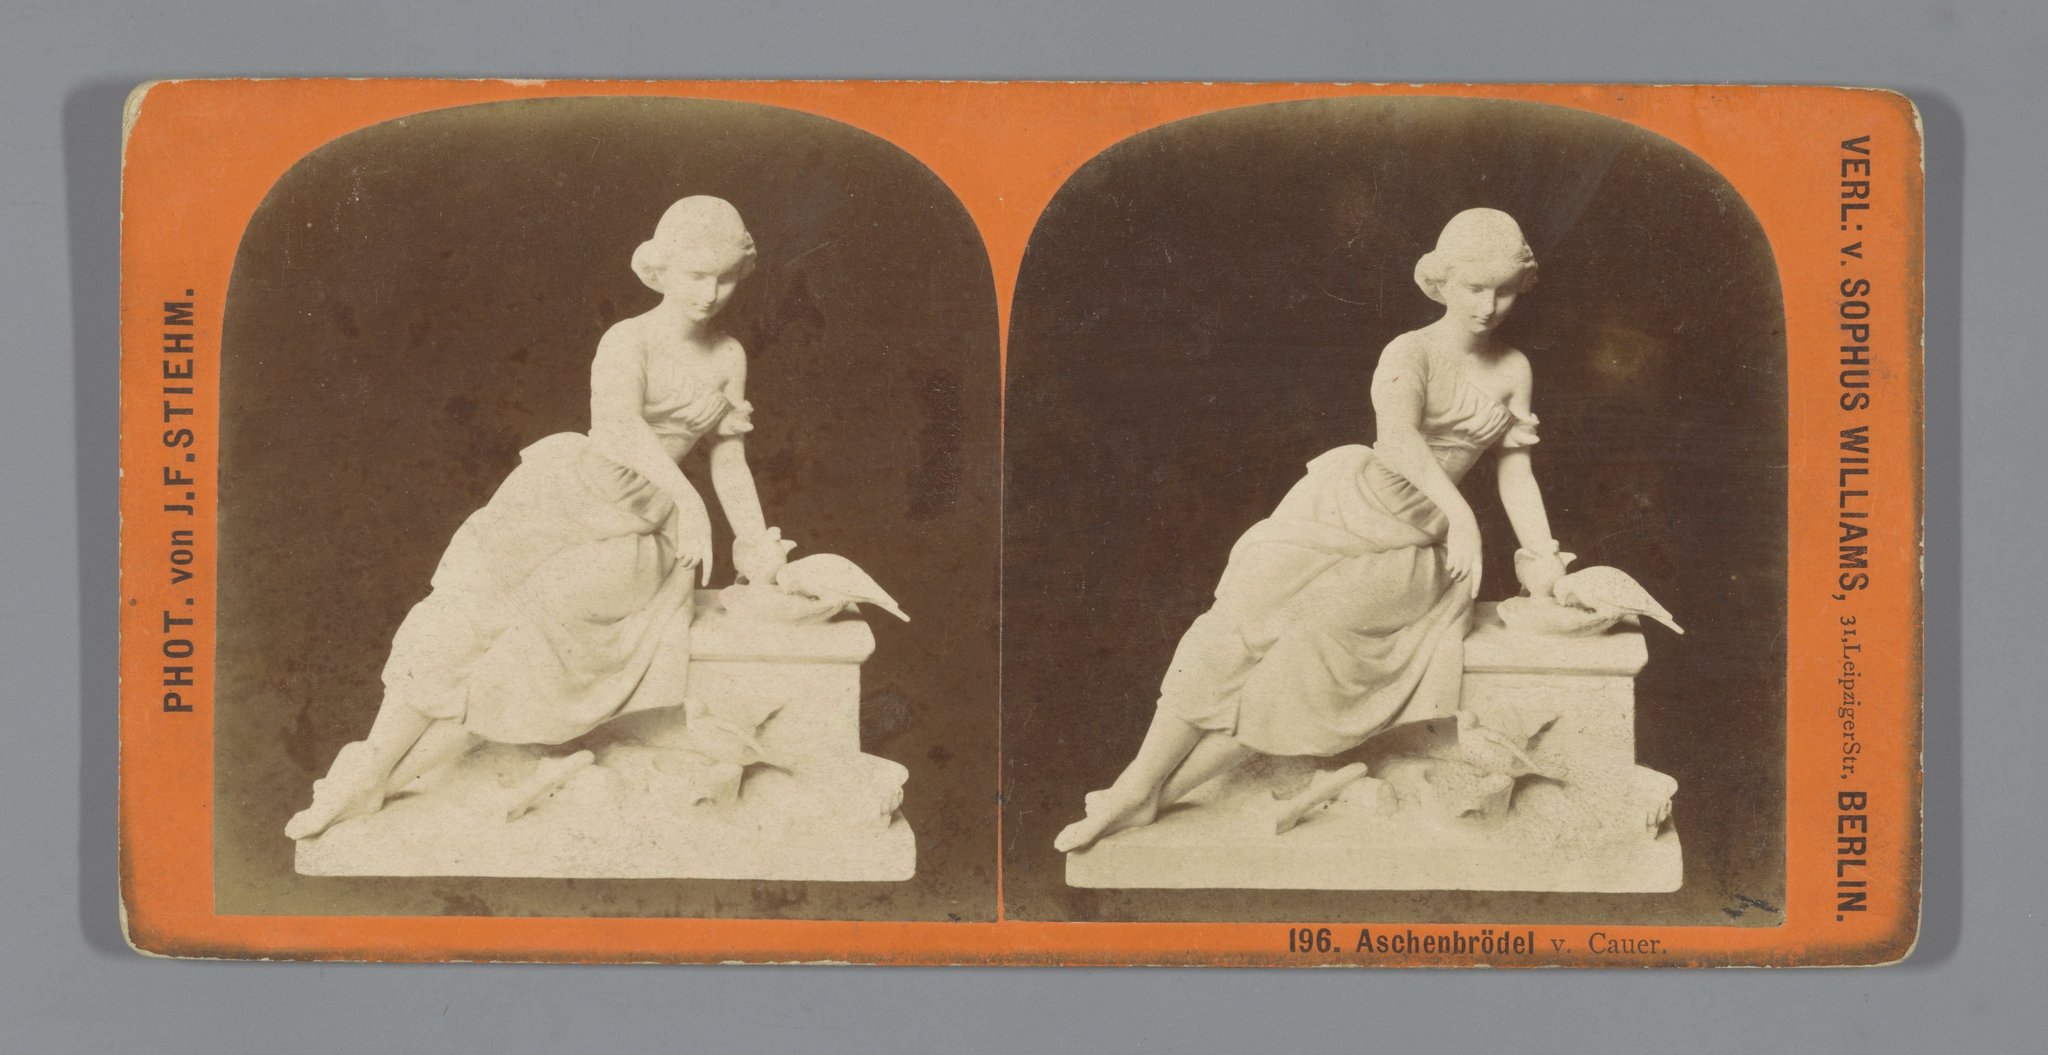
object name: stereograph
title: Aschenbrödel v. Cauer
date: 1855-1890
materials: cardboard, photographic support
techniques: albumen print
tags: sculptor, tales and fairy tales (with title), sculpture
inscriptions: number: ‘196’, : ‘31. Leipziger Str. Berlin’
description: Sculptuur van de Duitse beeldhouwer Robert Cauer.